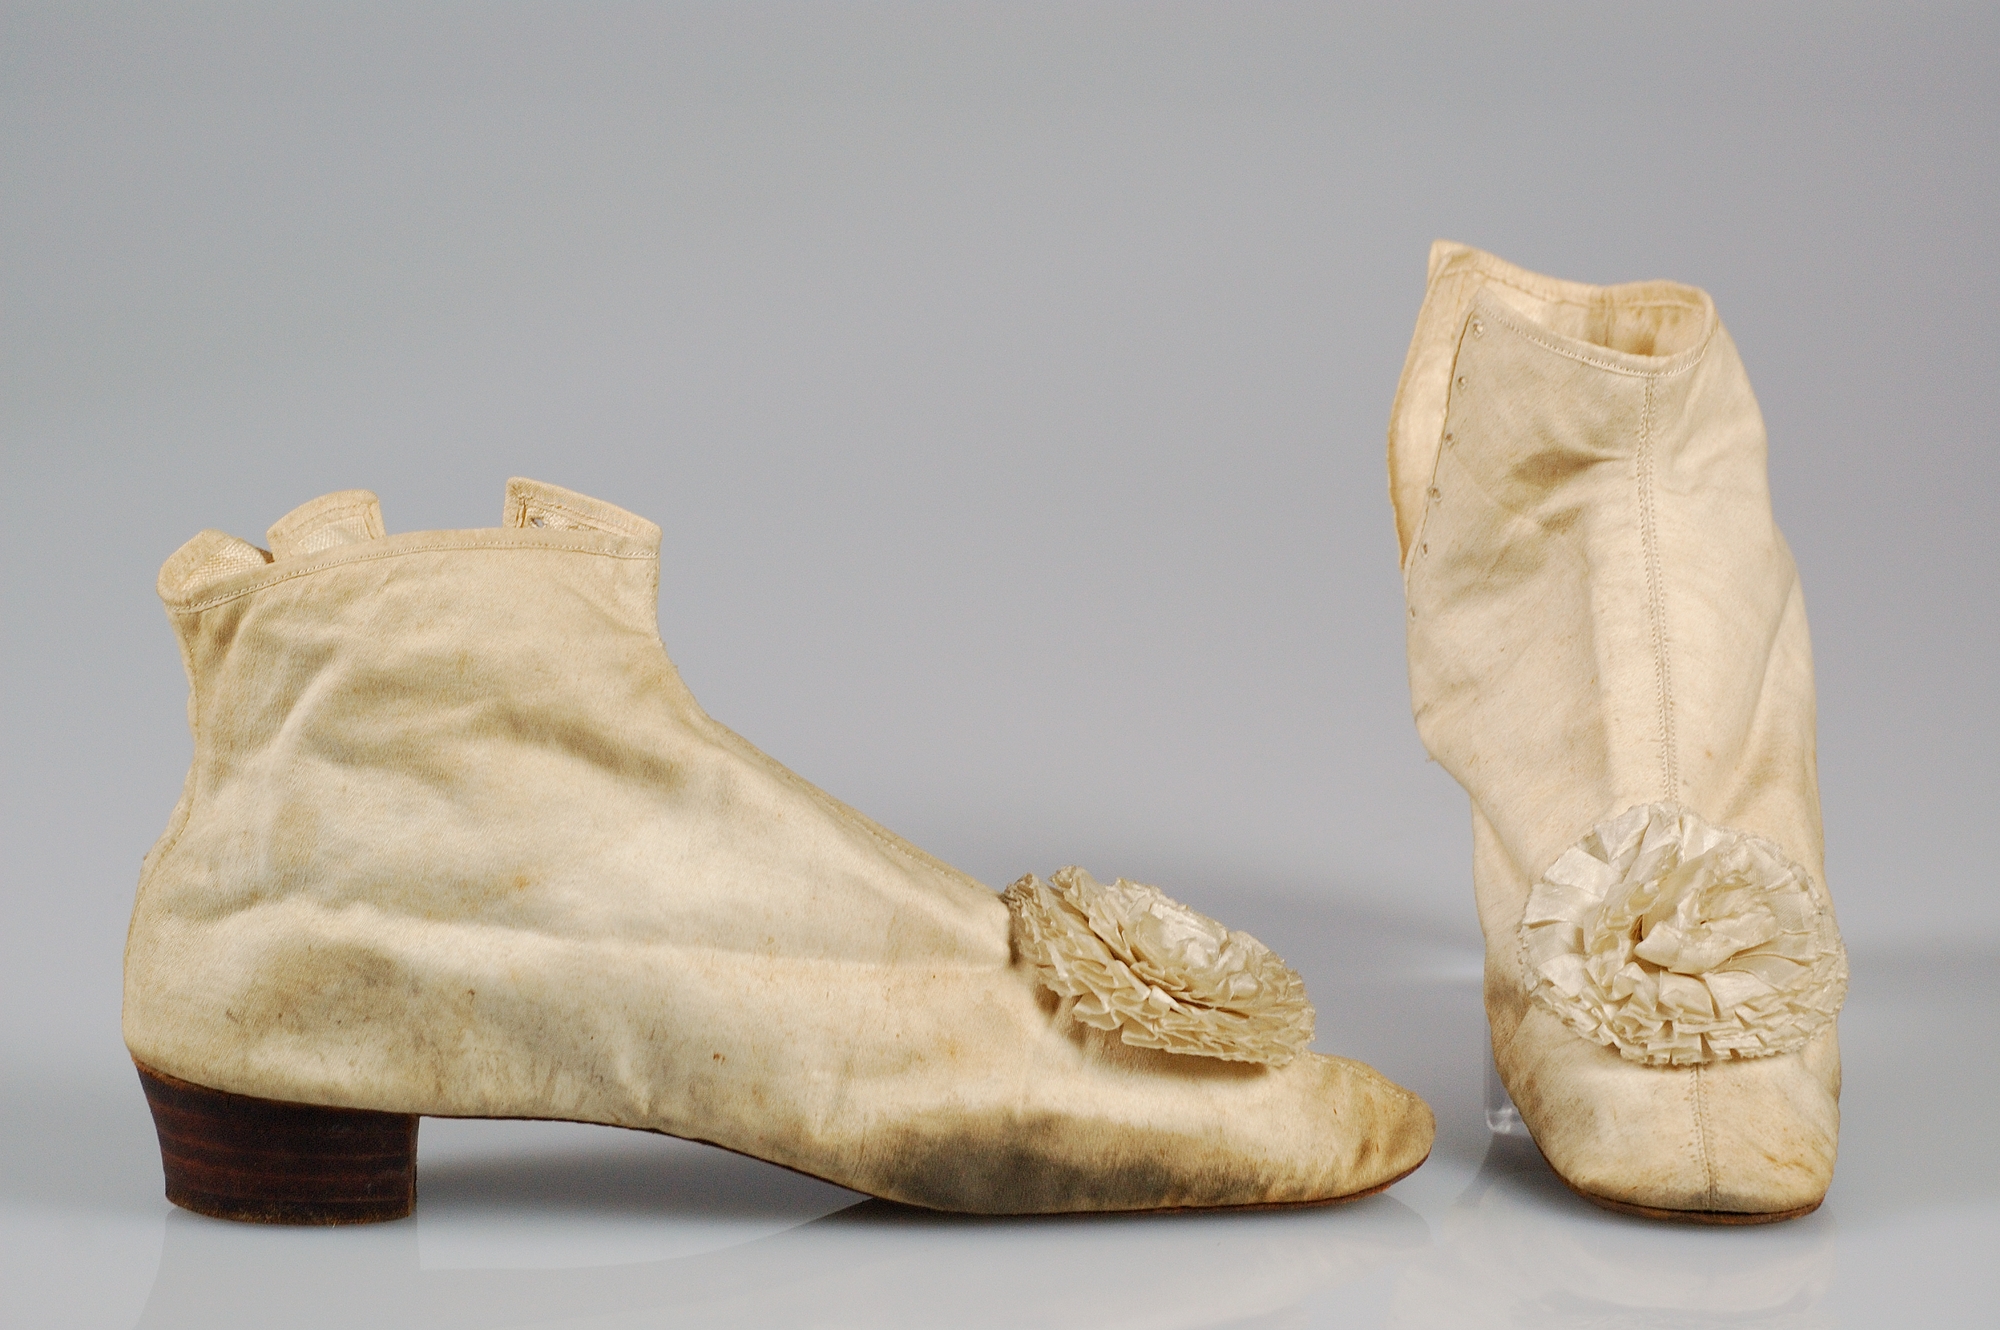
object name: walking boot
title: Walking boots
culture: american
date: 1855-1865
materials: cotton, silk